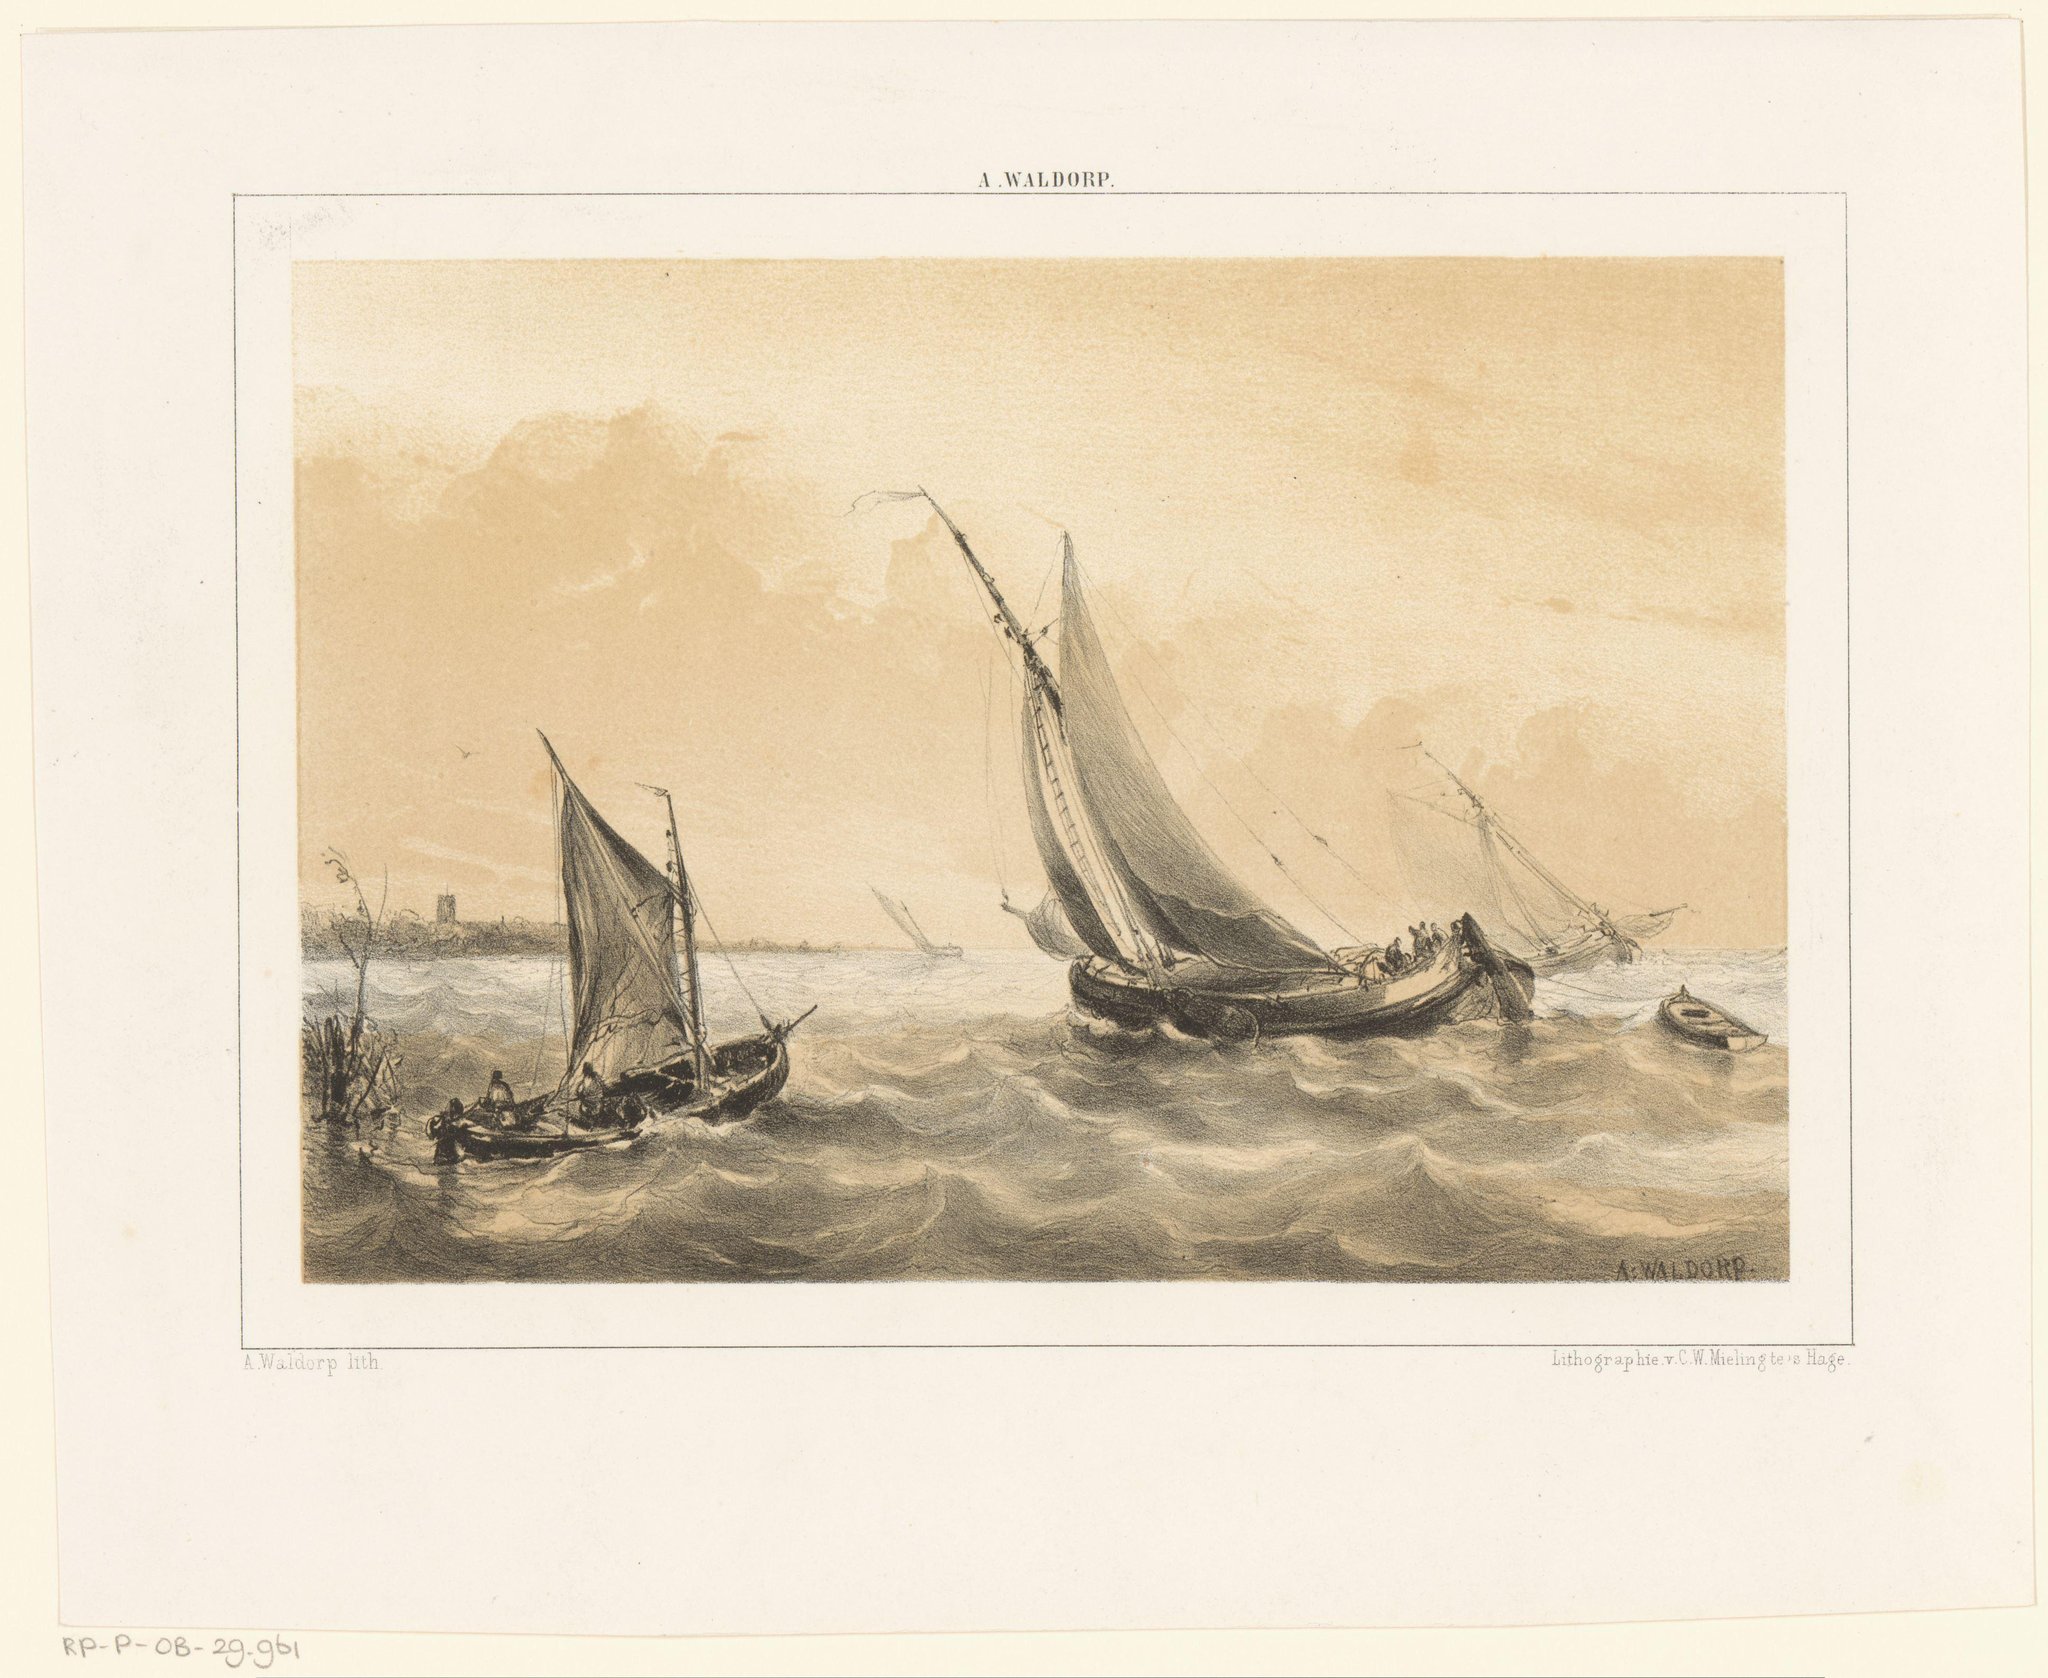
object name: print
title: Zeilboten op zee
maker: antonie waldorp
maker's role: draughtsman, painter, print maker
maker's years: 1803-1866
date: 1847-1865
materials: paper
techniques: tone lithography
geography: the hague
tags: sailing-ship, sailing-boat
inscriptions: collector's mark: Lugt 2228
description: Zeilboten op woelig water. In de achtergrond links de kust met een toren.